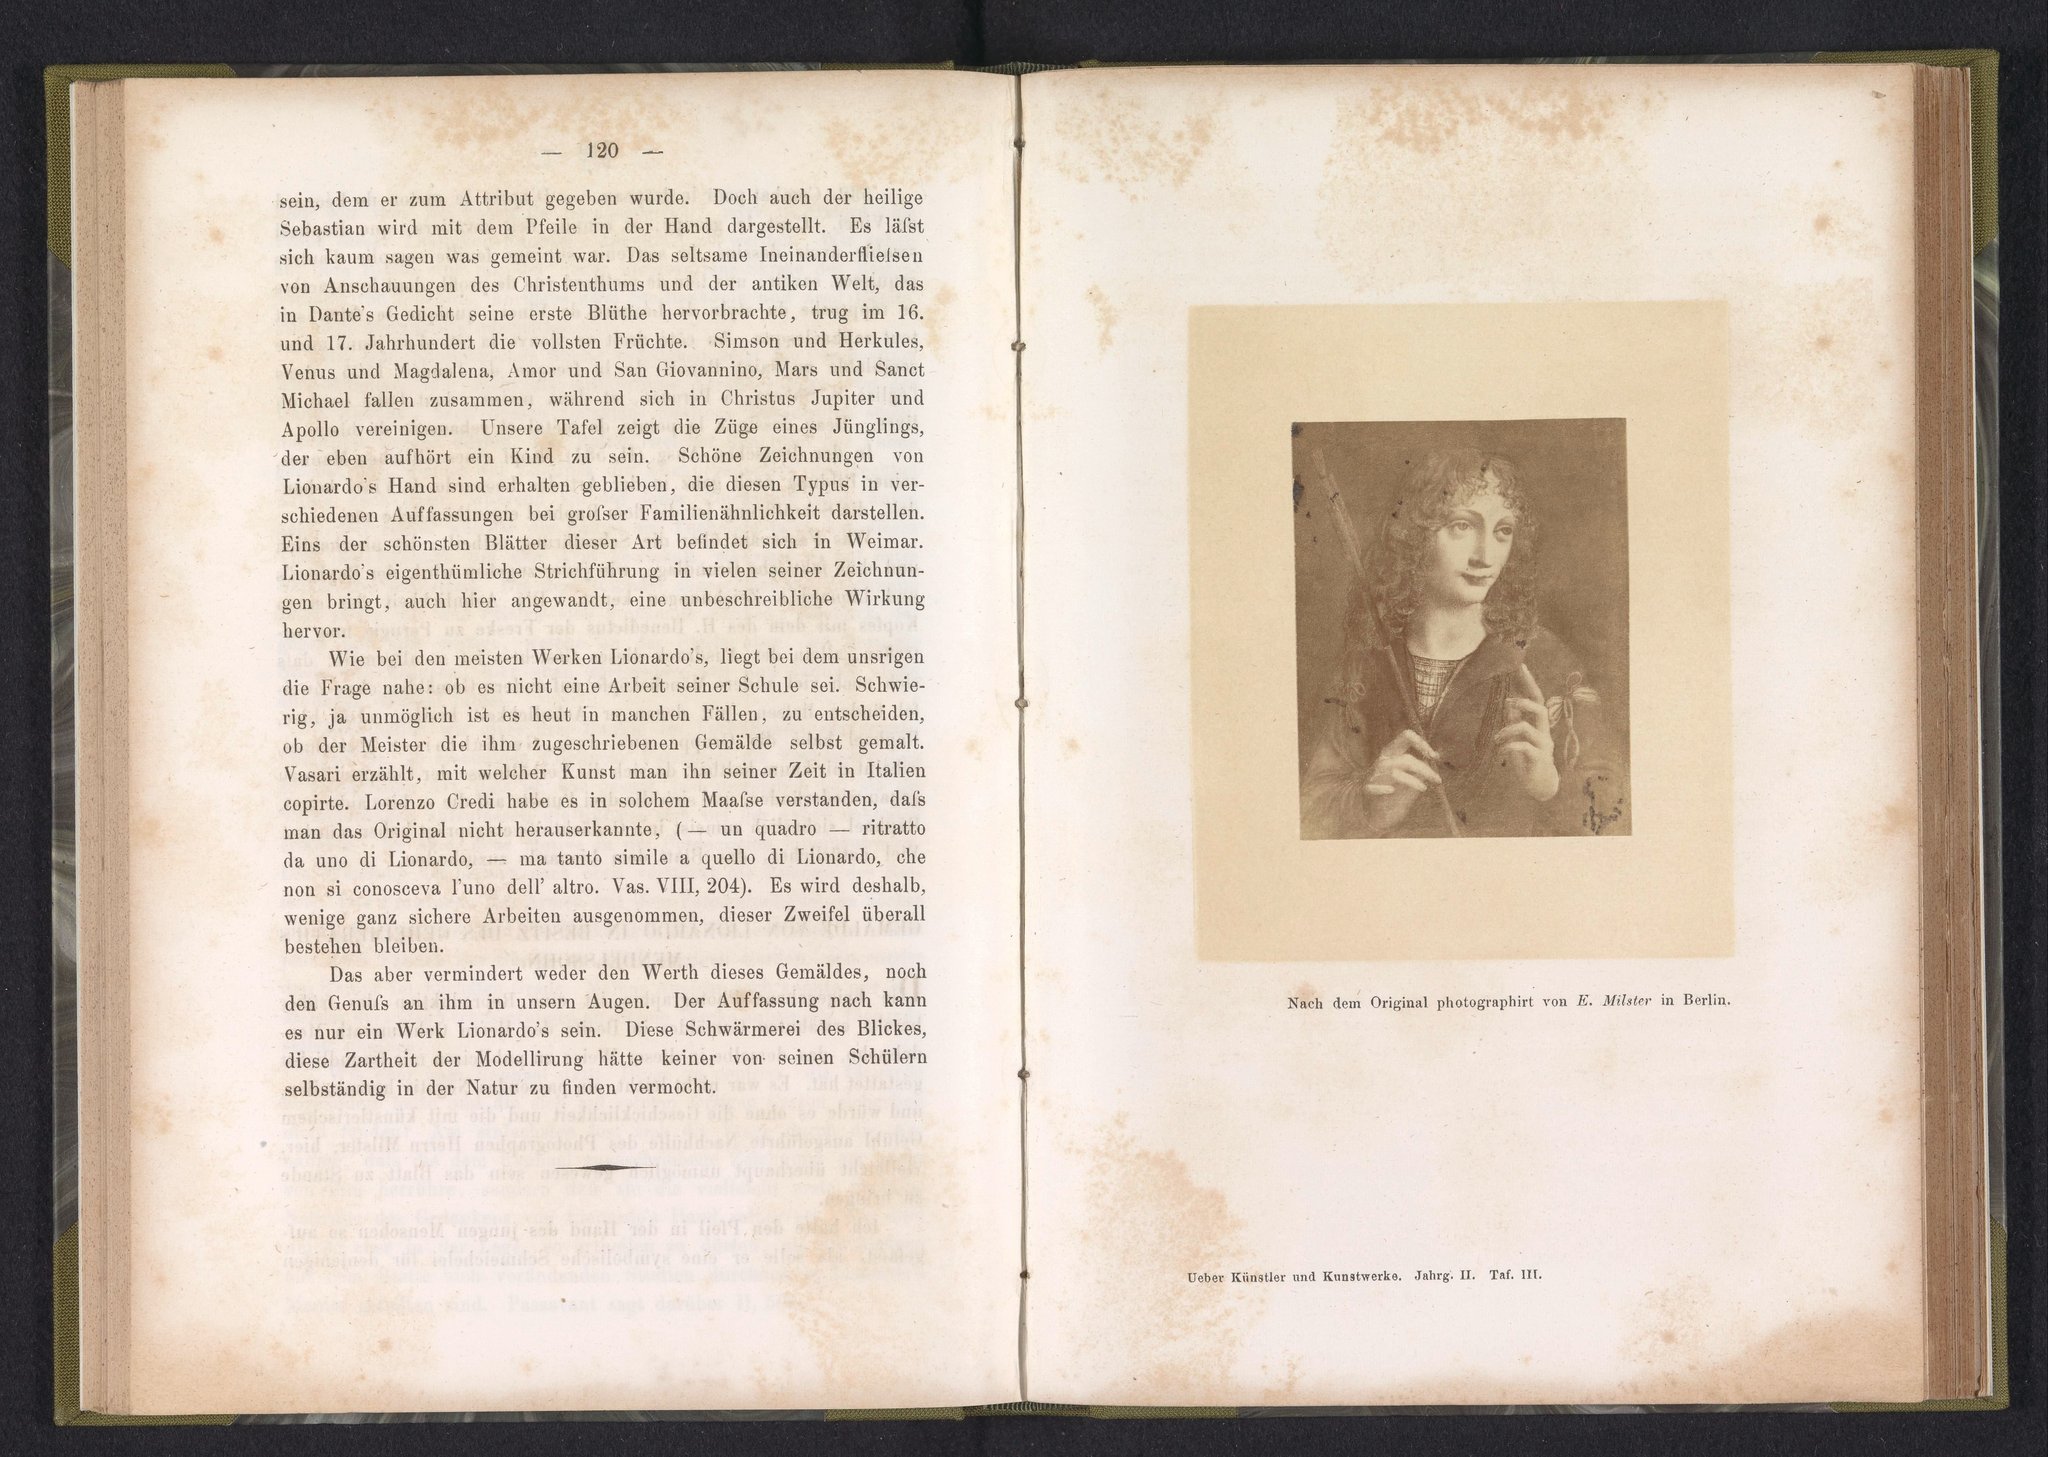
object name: reproduction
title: Fotoreproductie van een schilderij, voorstellende een portret van een jongen als de heilige Sebastiaan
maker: ernst milster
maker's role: fotograaf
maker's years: 1835-1908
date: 1862-1867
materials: photographic support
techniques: albumen print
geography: berlin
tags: the martyr sebastian; possible attributes: arrow(s), bow, tree-trunk, youth, adolescent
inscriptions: number: ‘Tafel III.’